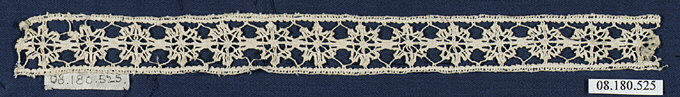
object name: fragment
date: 1501-1600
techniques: lace